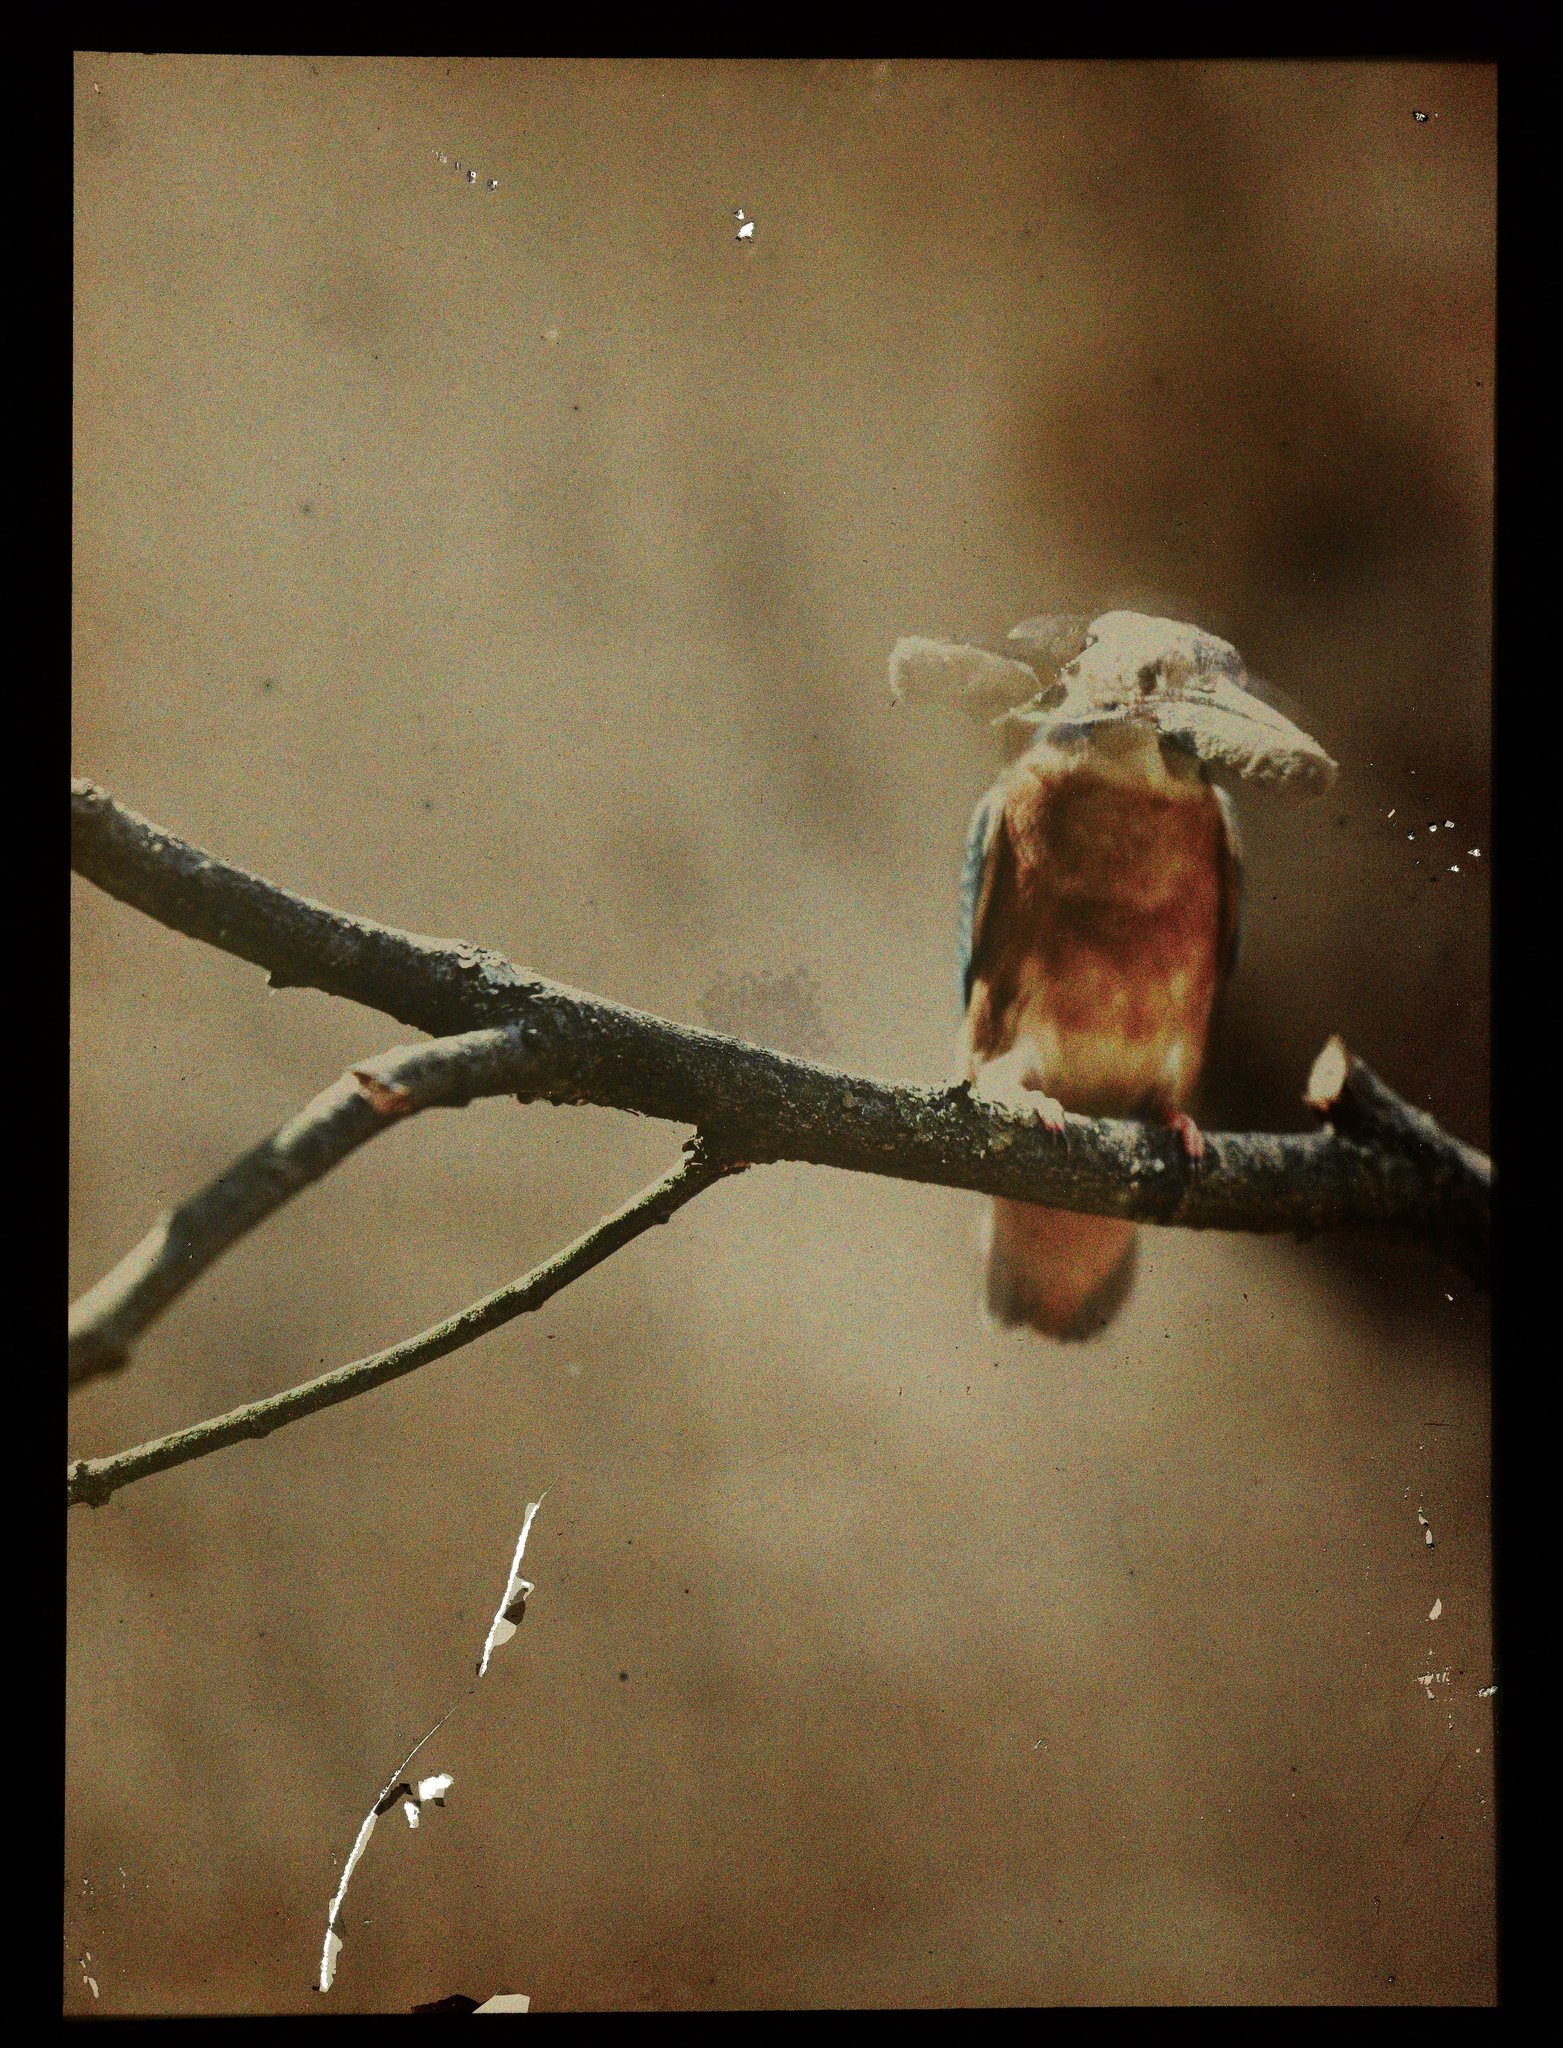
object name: color slide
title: IJsvogel op een tak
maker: adolphe burdet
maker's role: fotograaf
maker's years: 1860-1940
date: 1907-1930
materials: glass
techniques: autochrome process, slide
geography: netherlands